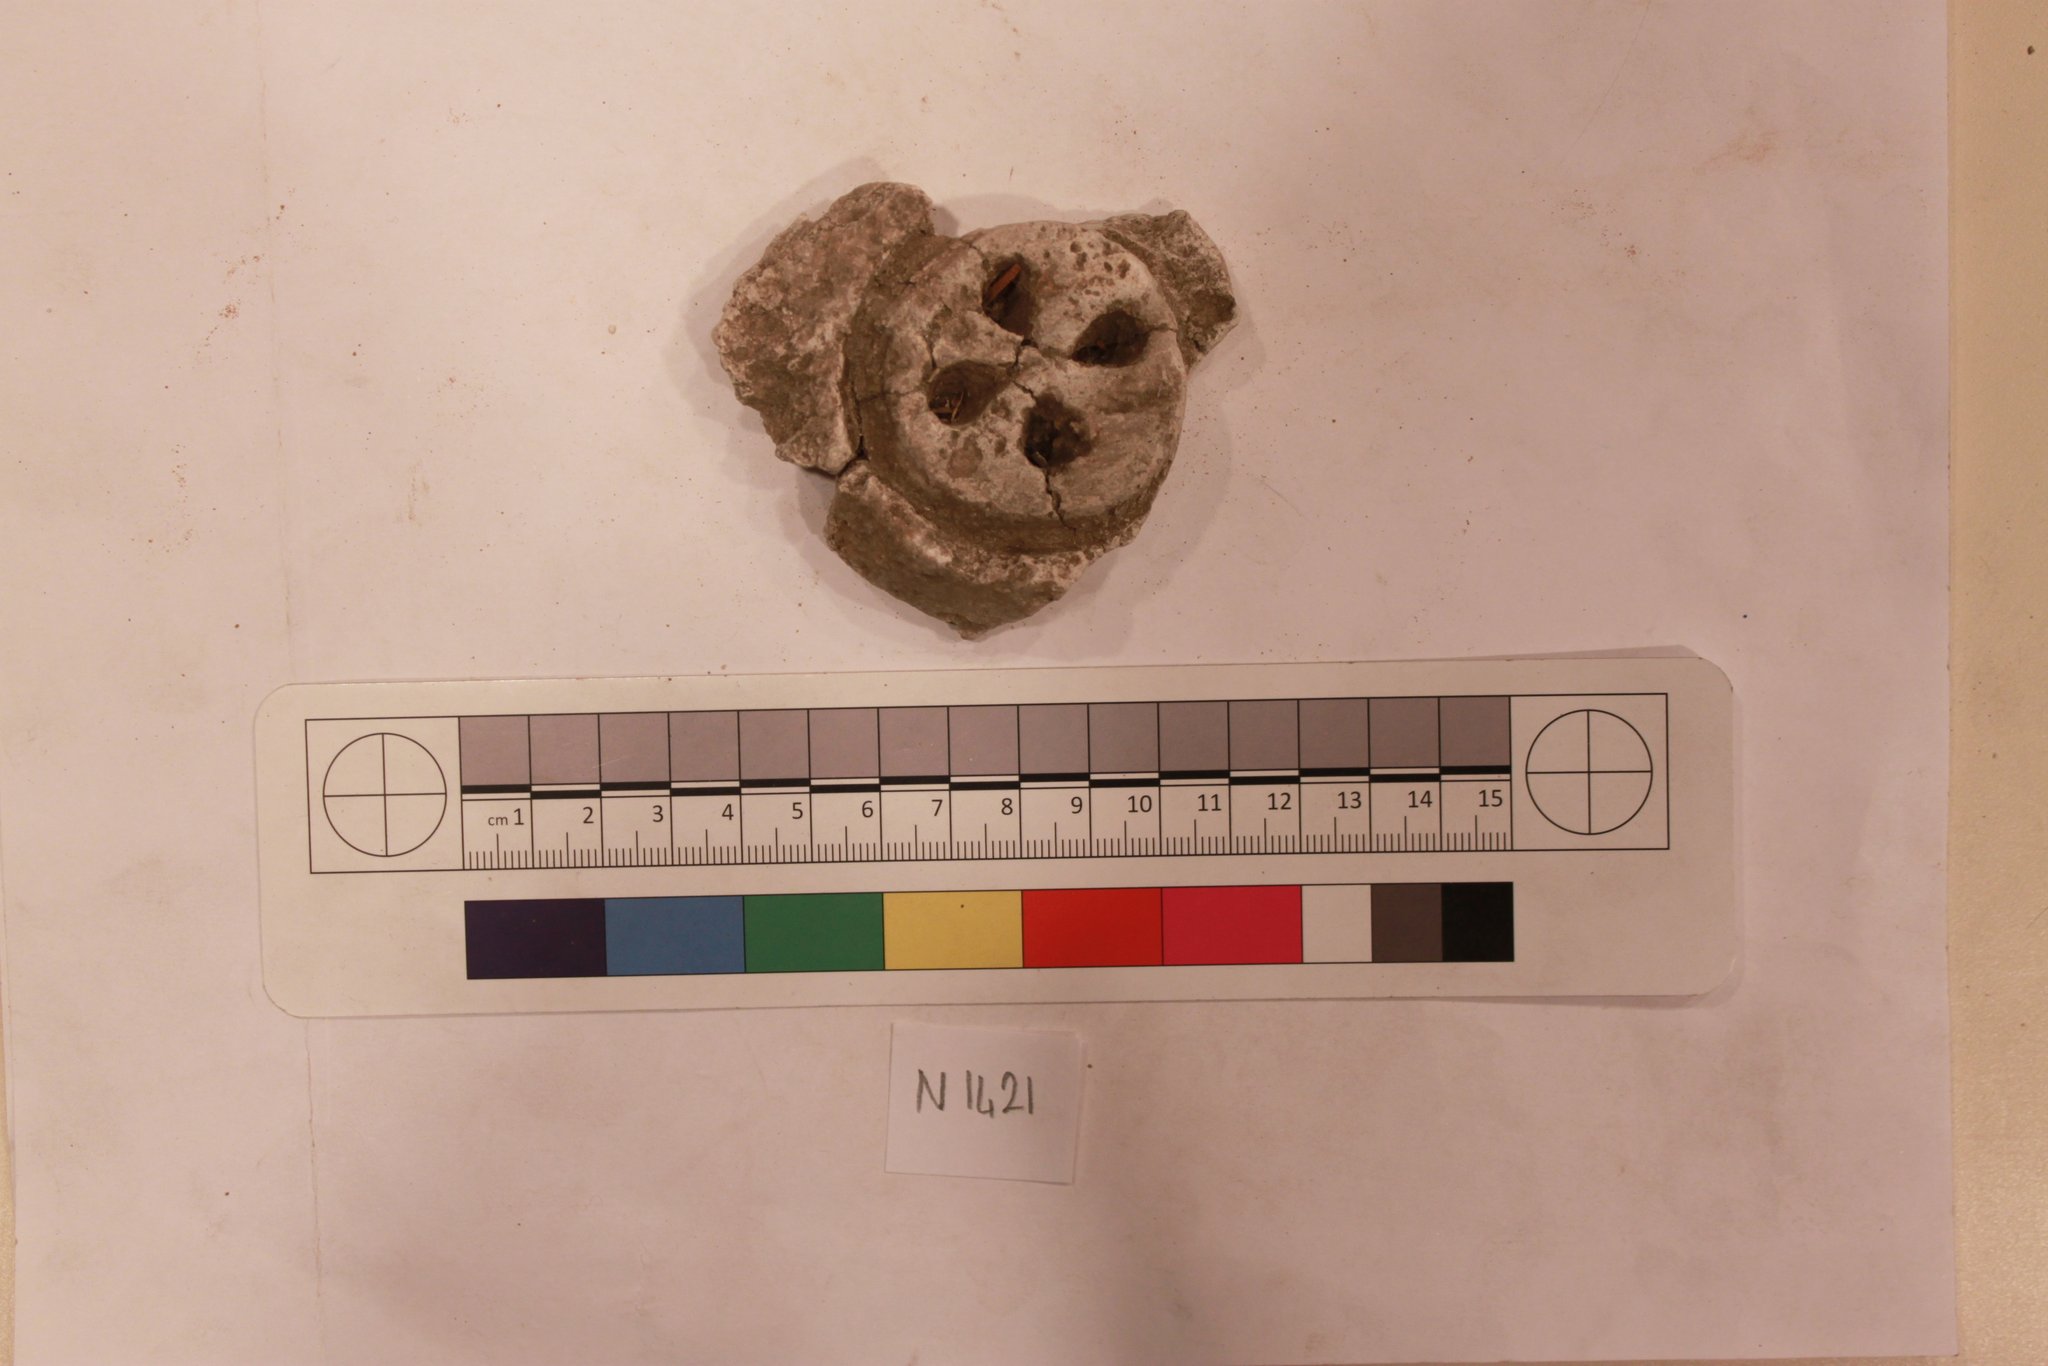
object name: fragment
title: Stucco Fragment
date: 701-1200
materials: plaster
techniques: carving, painting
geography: iran